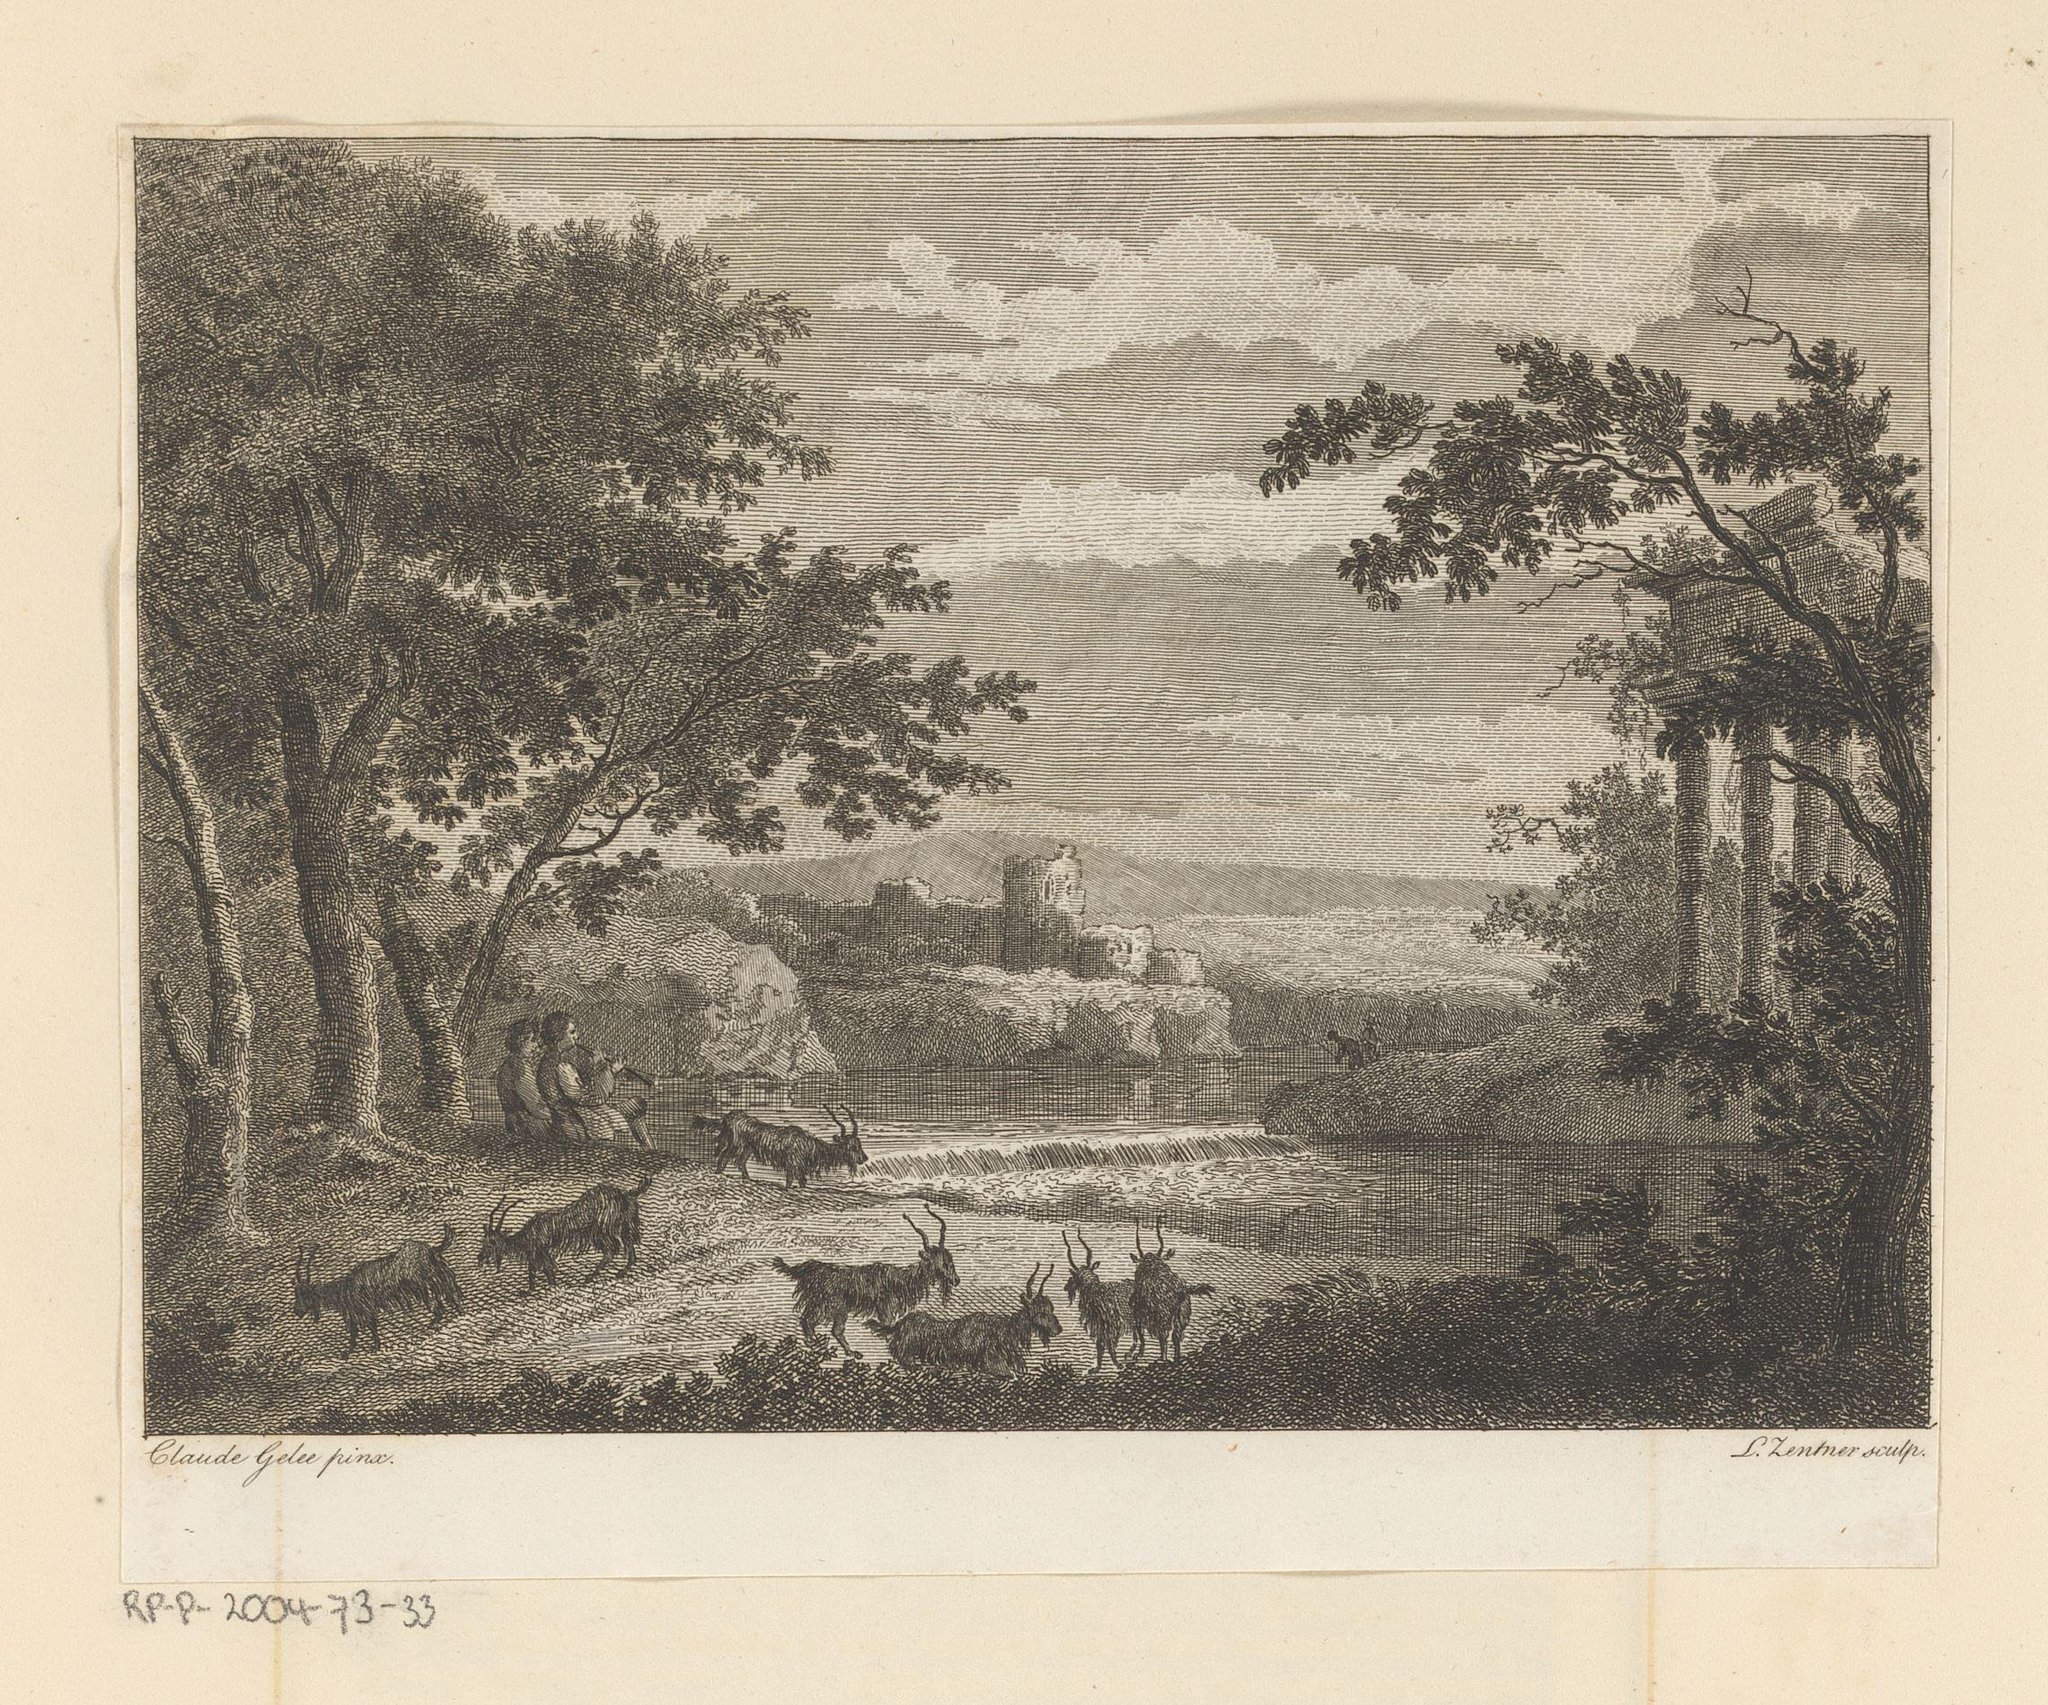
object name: print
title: Rivierlandschap met ruïnes, herders en geiten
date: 1791-1798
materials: paper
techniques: engraving, etching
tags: landscape with ruins (+ city(-scape) with figures, staffage), river bank (+ landscape with figures, staffage)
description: Prent uit: Zentner, J.L.L.C.. A select Collection of landscapes, from the best old masters, one of each engraved by L. Zentner, after drawings made by him from original pictures (...). Londen: J. Thane, [1791-1798]. De samensteller heeft deze prent in het album geplakt als illustratie bij: Pilkington, Matthew en Johann Heinrich Füssli. A dictionary of painters, from the revival of the art to the present period. 4 dln. Londen: John Crowder, 1805, dl. 2, p. 213.